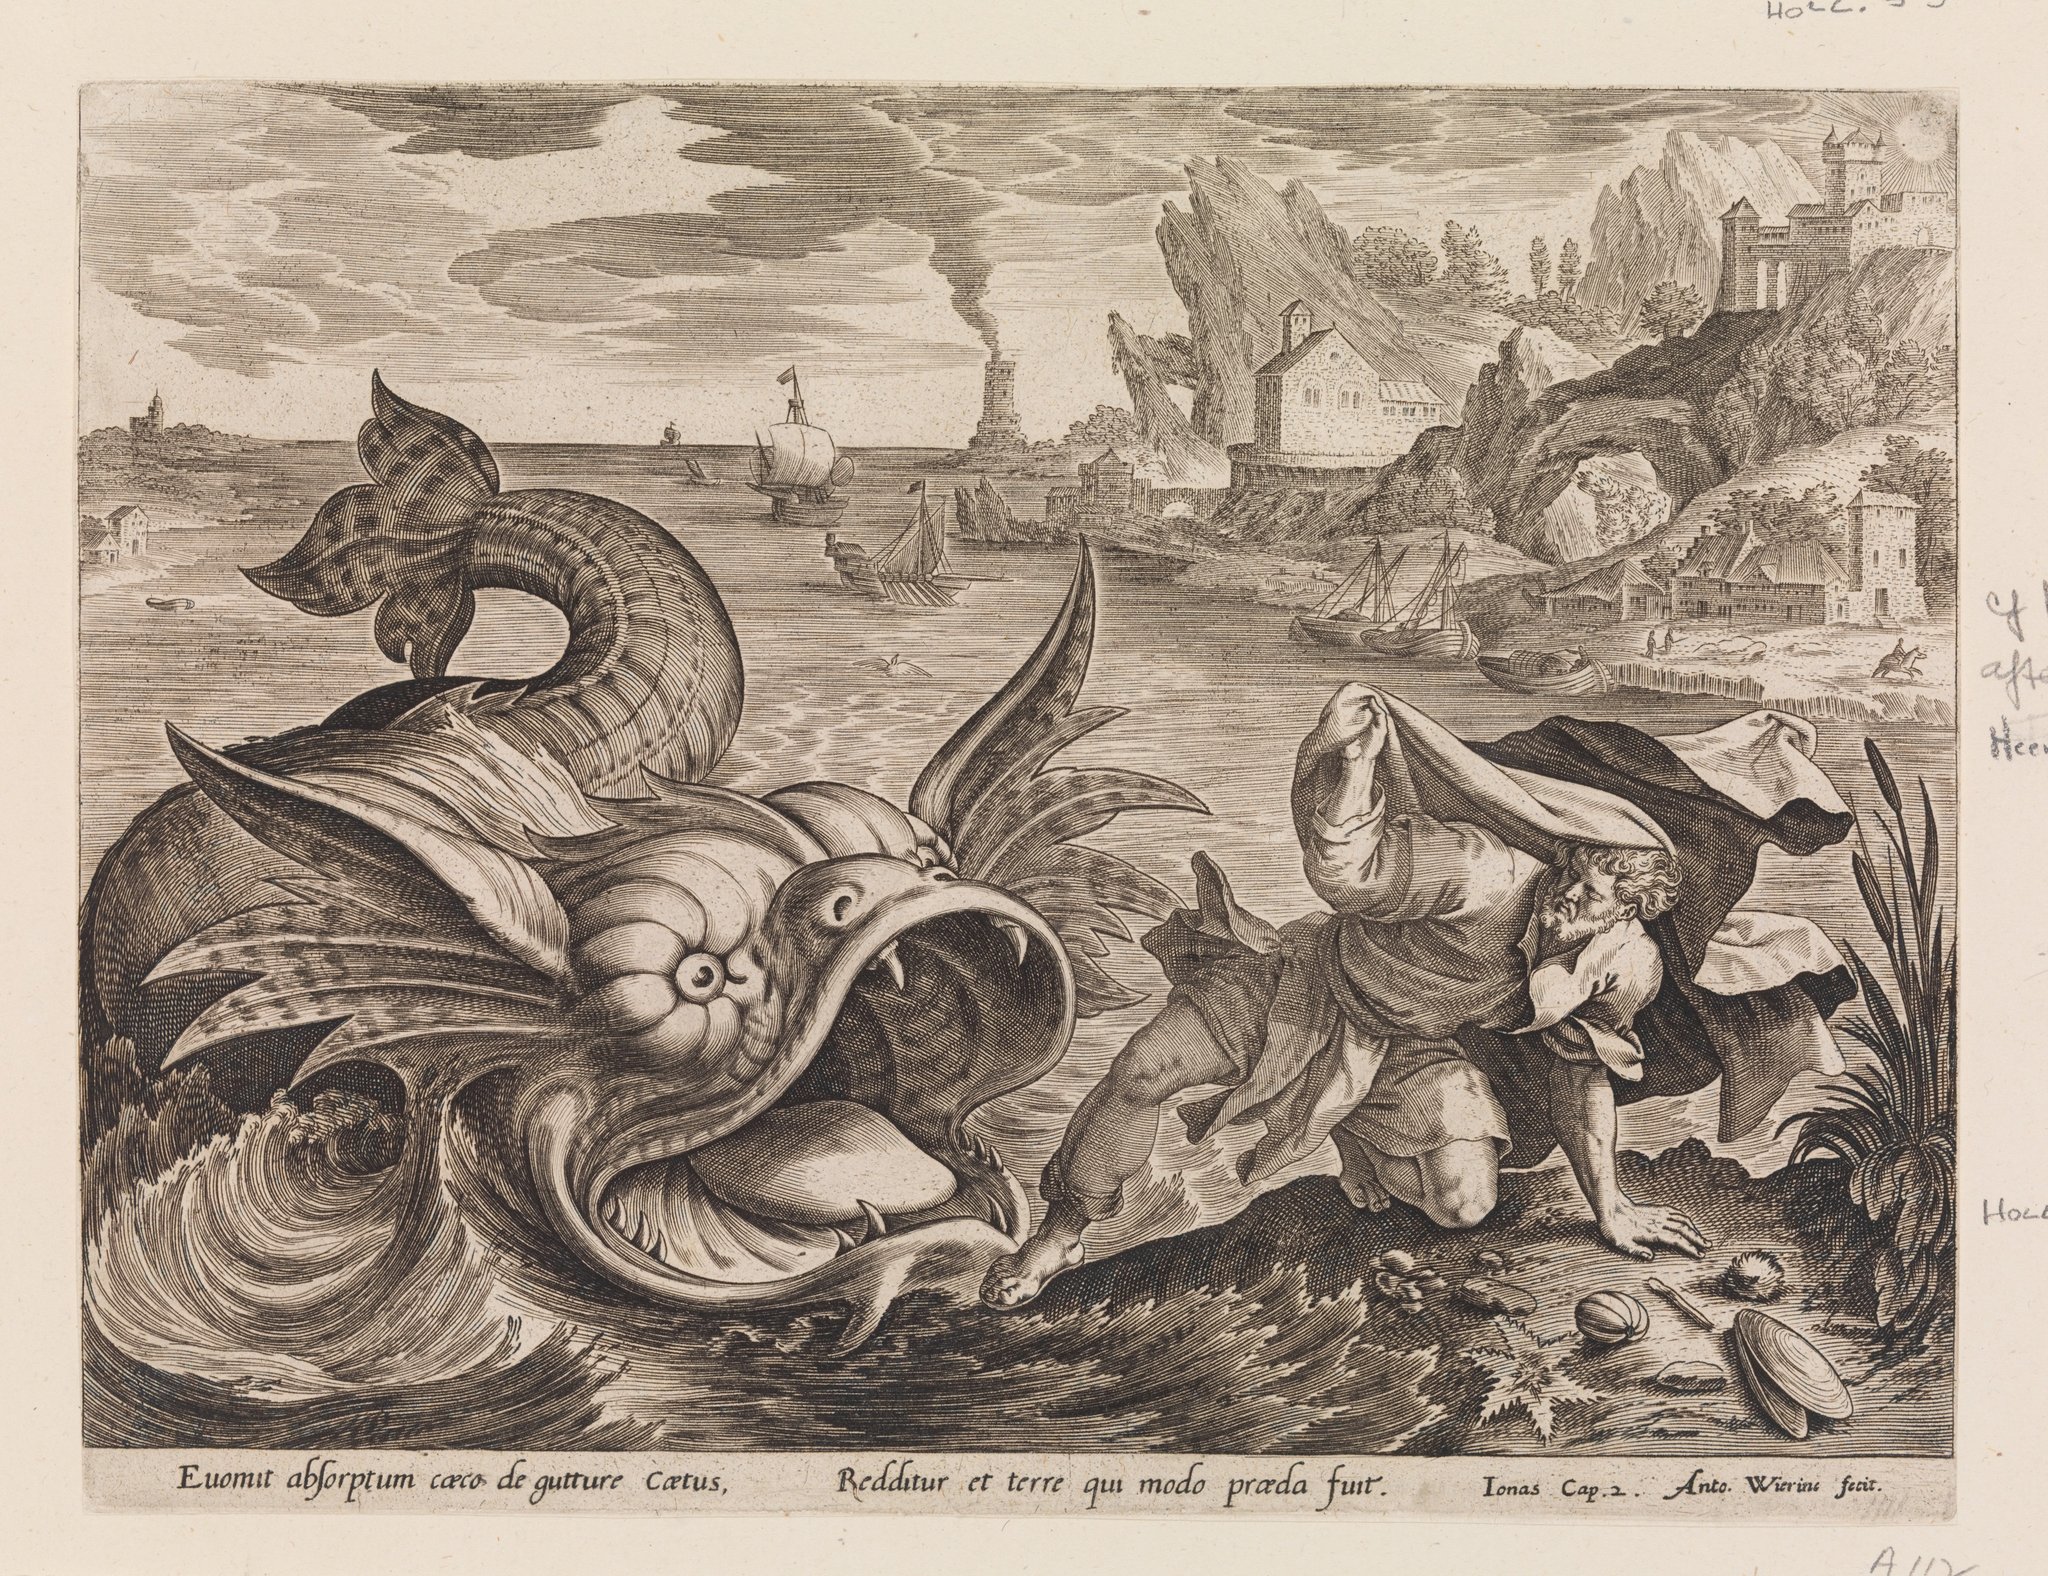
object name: print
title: Jonah Cast on Shore by the Fish, from "The Story of Jonah," a set of four plates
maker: maerten de vos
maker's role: artist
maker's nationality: netherlandish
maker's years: 1532-1603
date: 1585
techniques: engraving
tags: men,fish